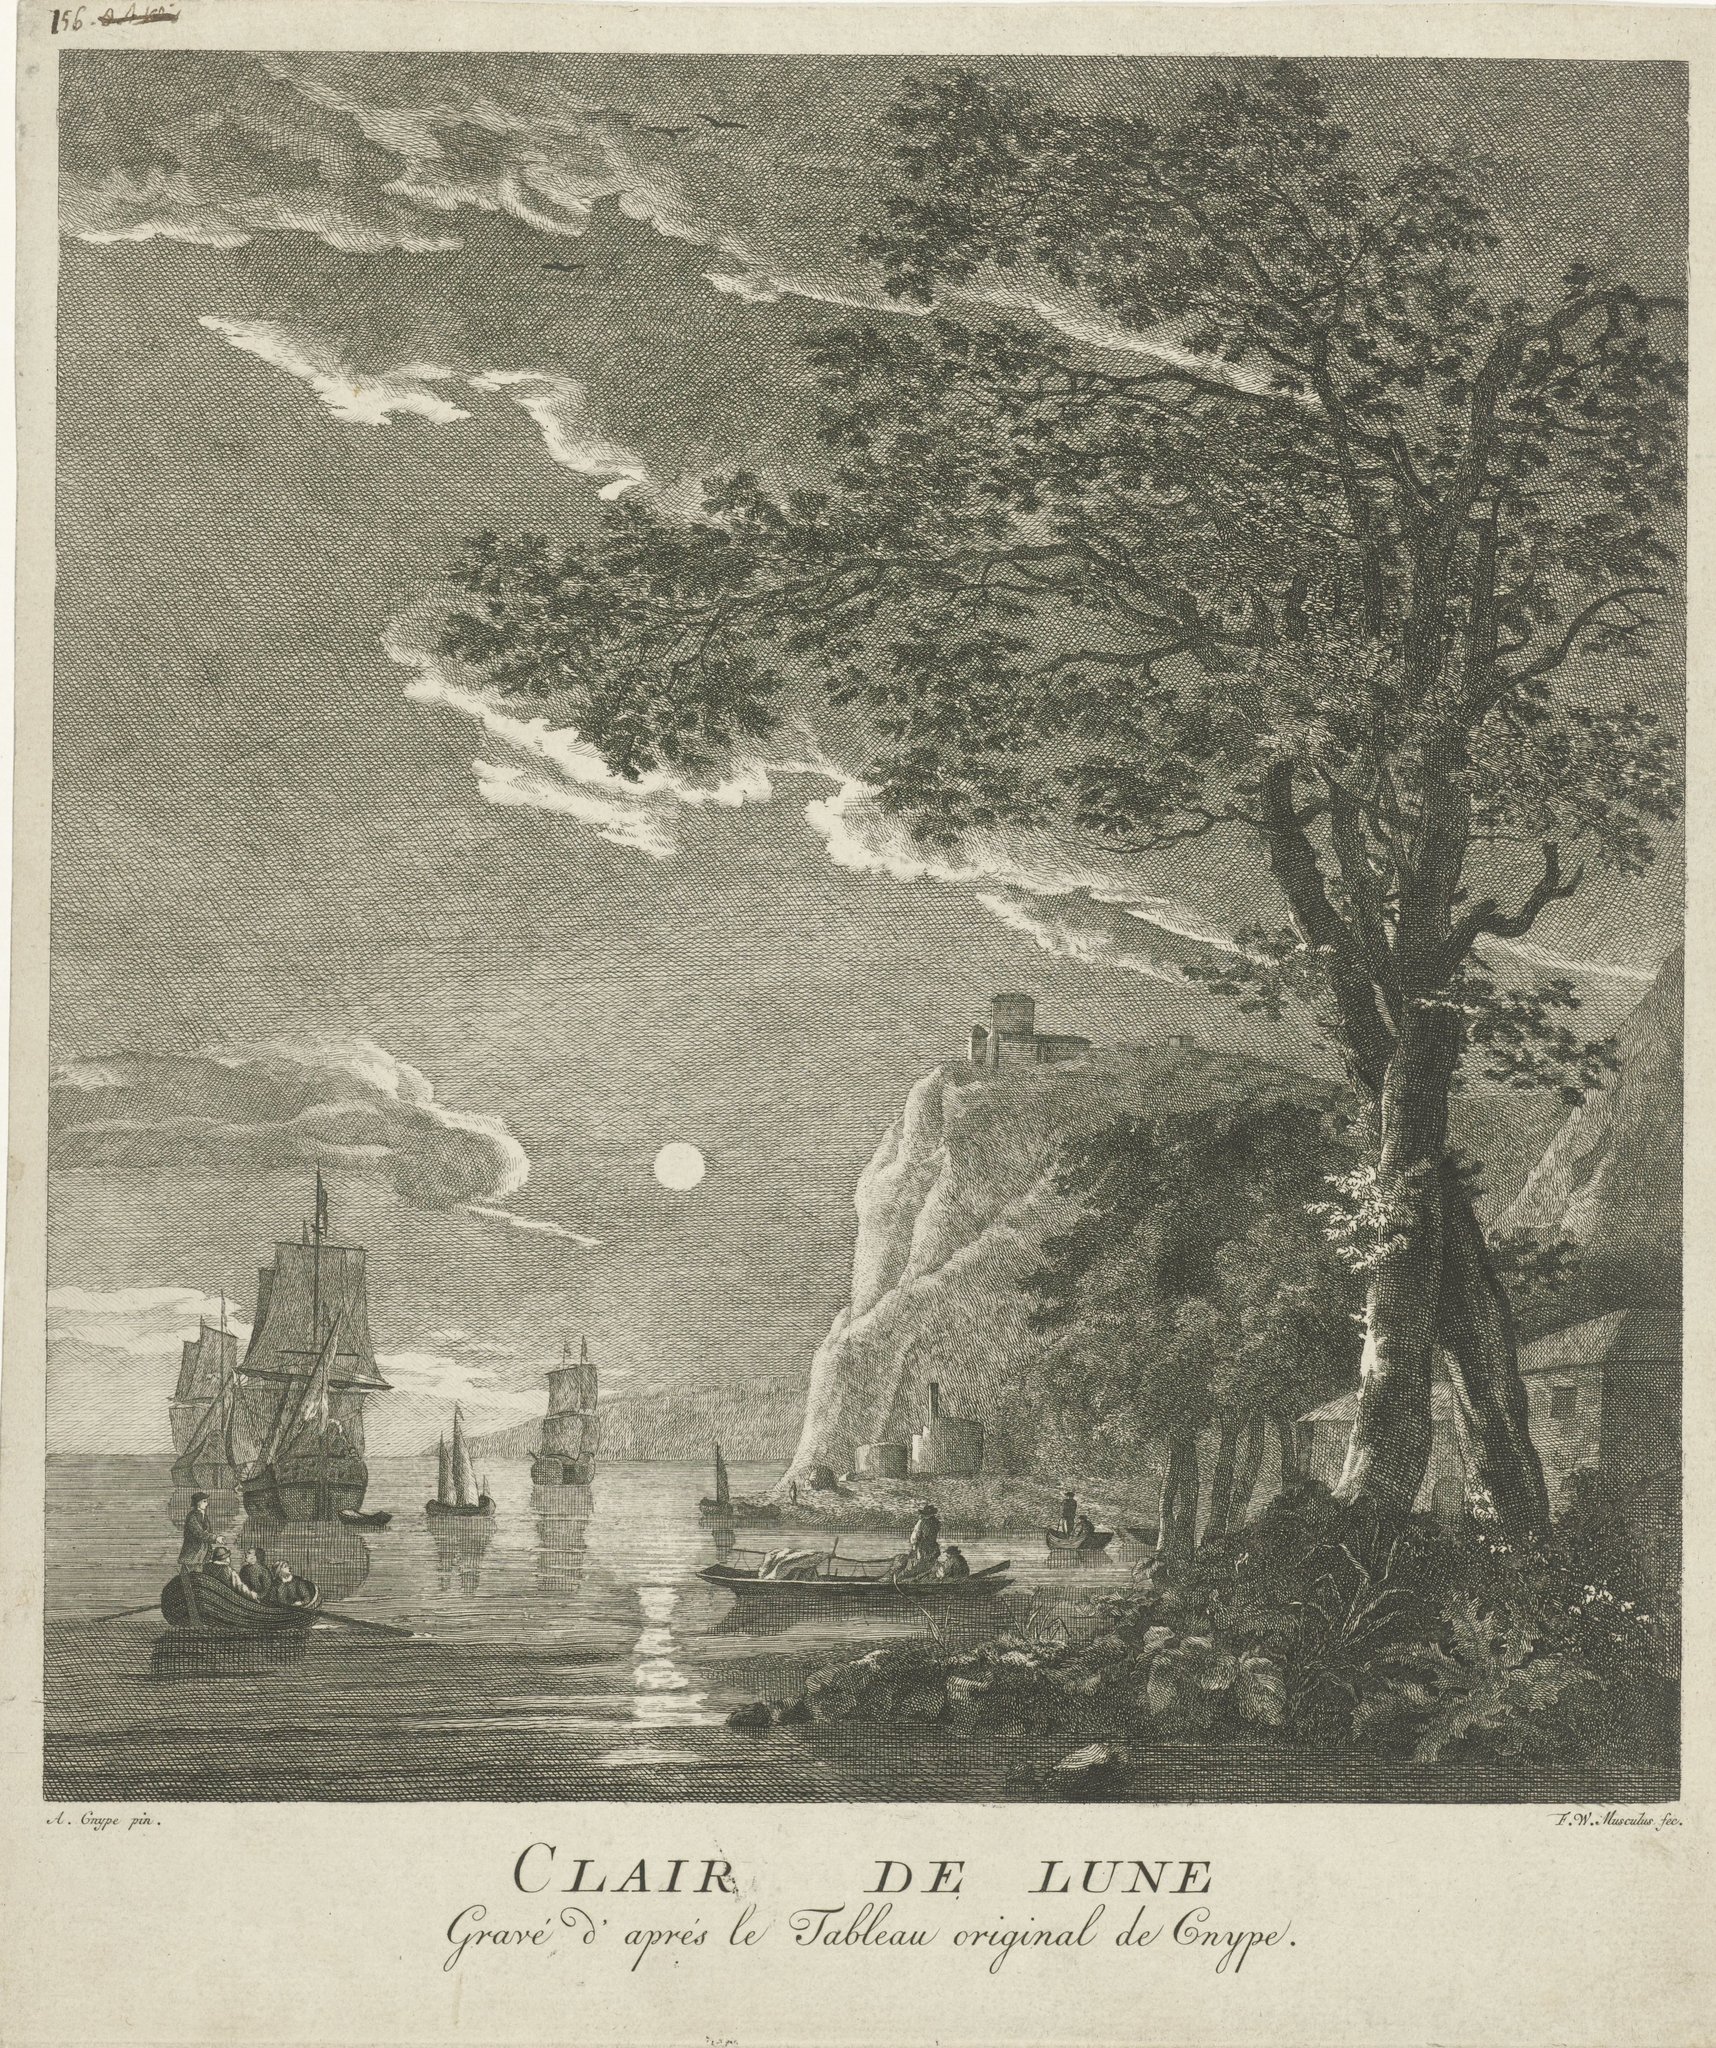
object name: print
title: Clair de lune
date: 1750-1799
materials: paper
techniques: engraving, etching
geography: amsterdam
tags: sailing-ship, sailing-boat, moonlight, coast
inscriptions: collector's mark: Lugt 2228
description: Een kustlandschap bij maanlicht. Op zee varen zeilschepen en op de voorgrond een roeiboot en een platte schuit. Rechts gebouwen op een klif.